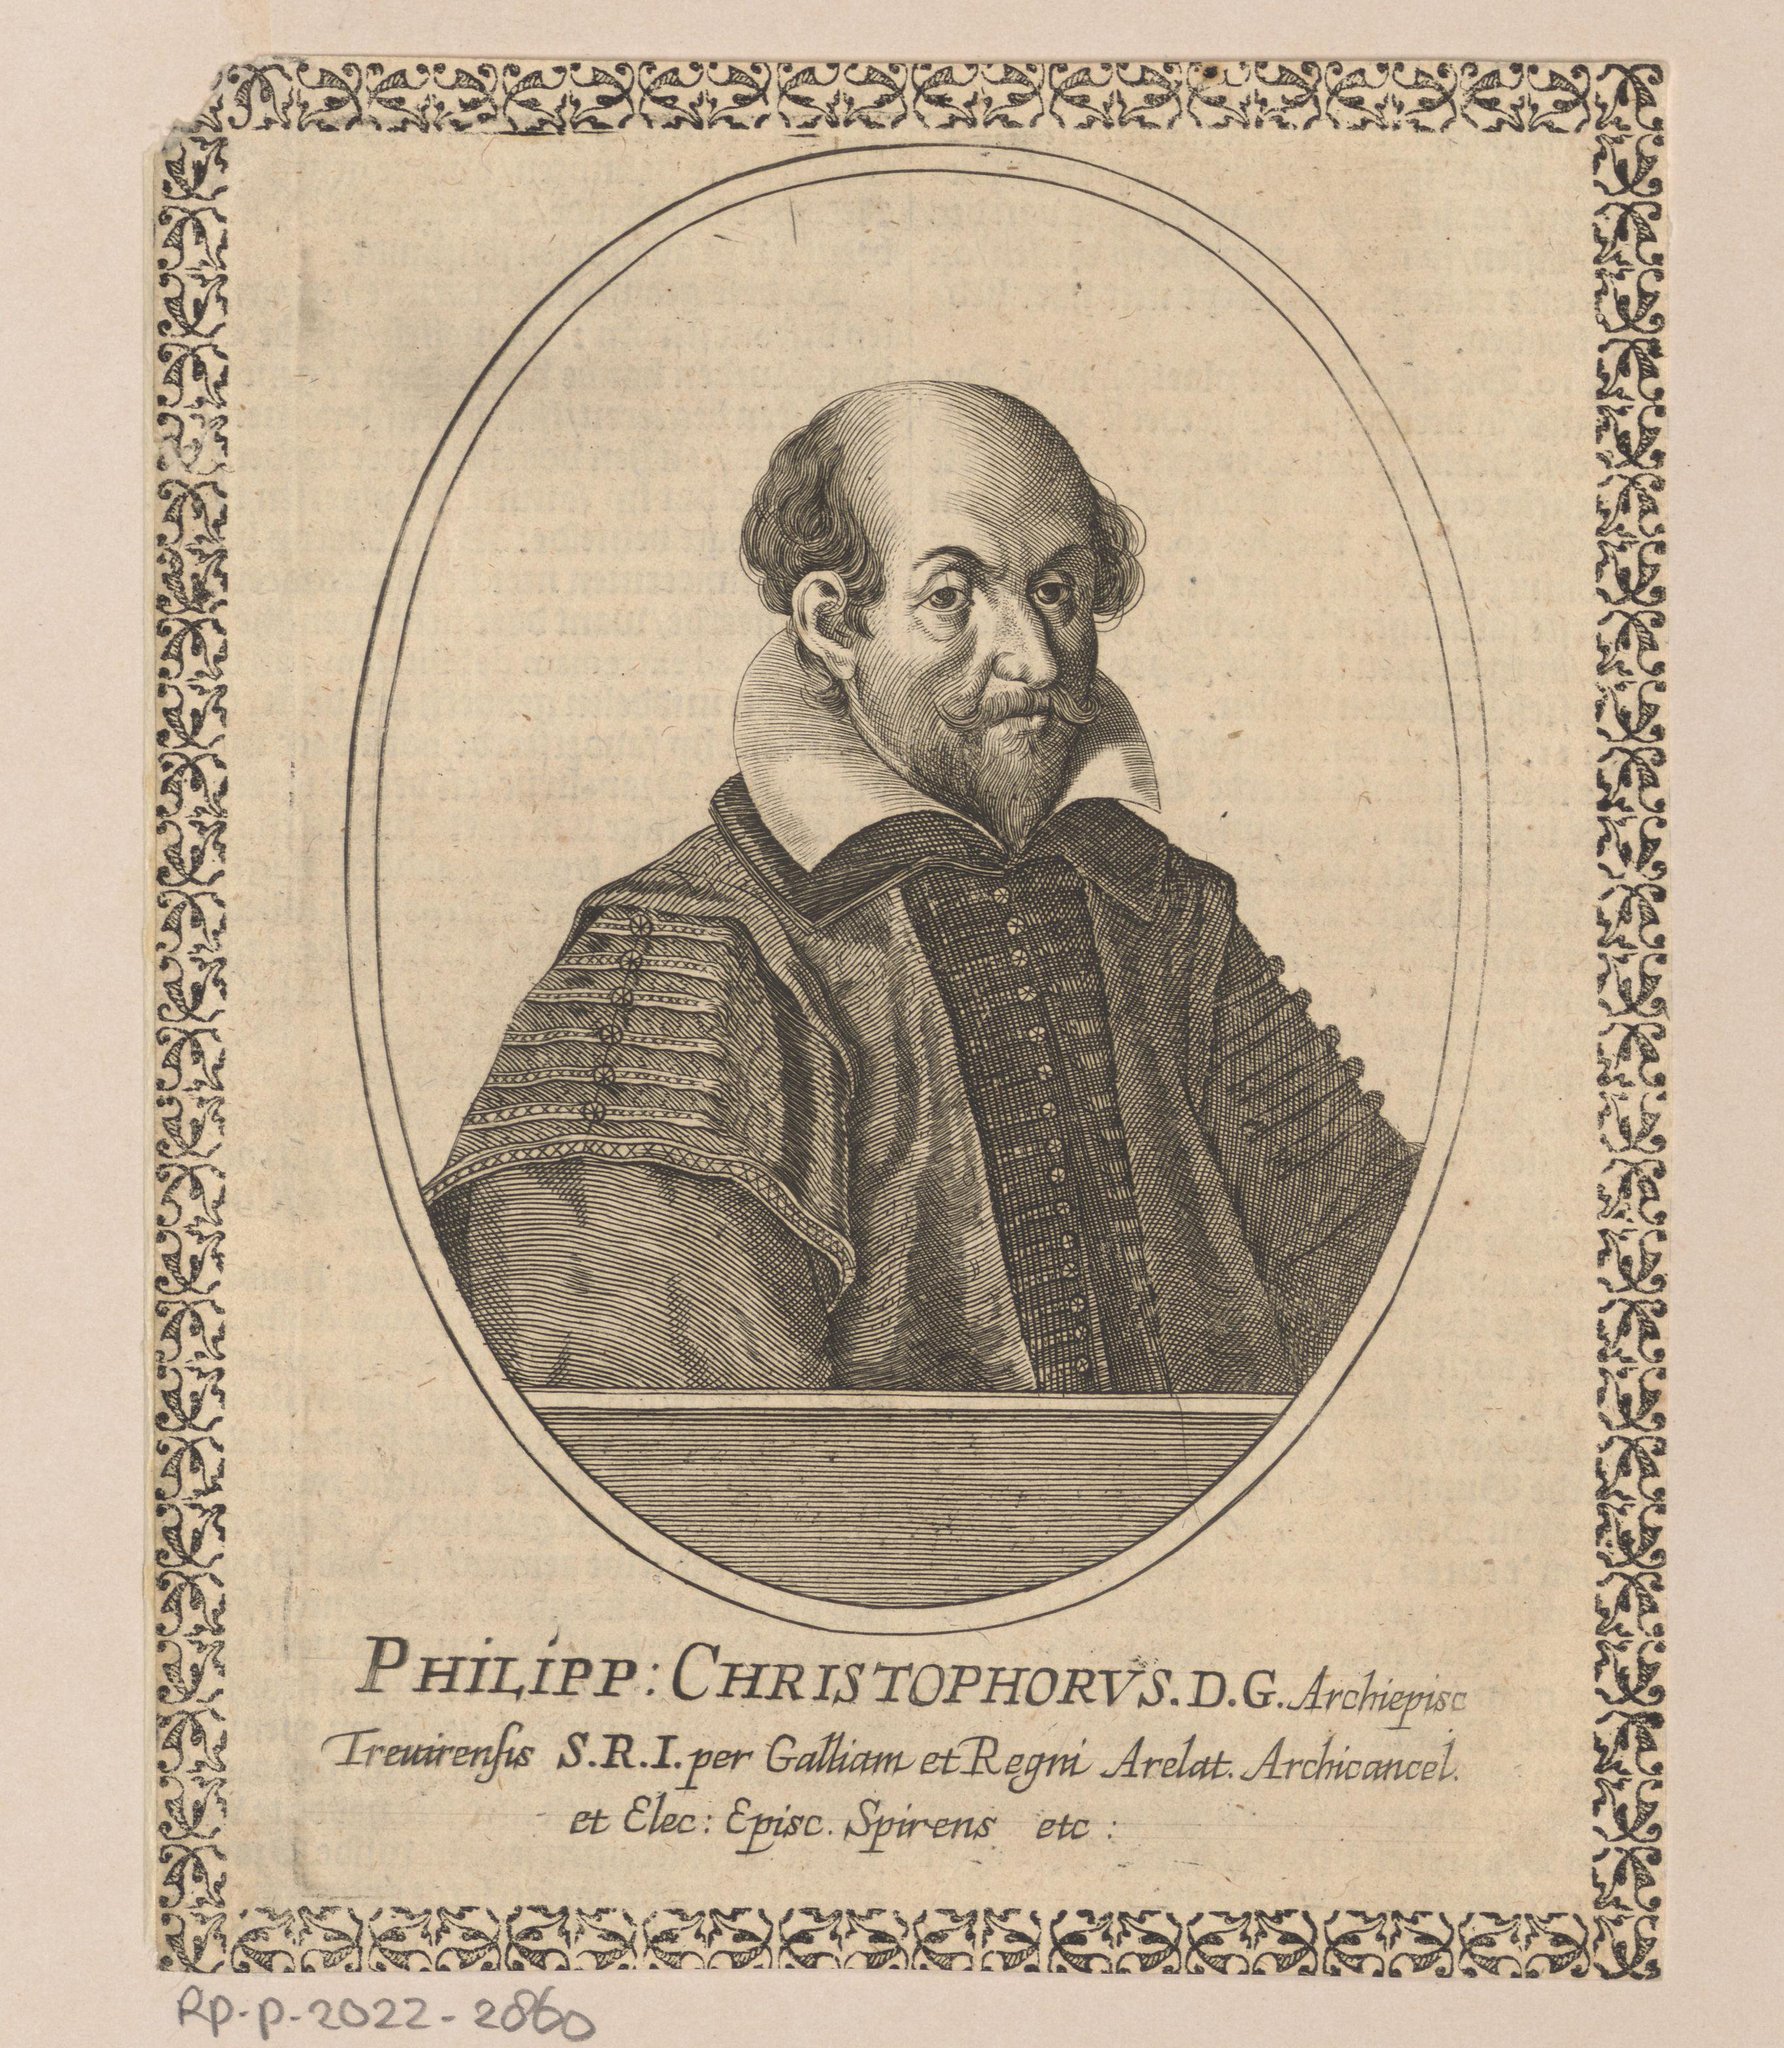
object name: print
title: Portret van Philipp Christoph von Sötern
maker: cornelis danckerts (i)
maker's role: print maker, publisher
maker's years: 1604-1656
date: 1642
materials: paper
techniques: engraving, etching, letterpress printing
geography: amsterdam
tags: archbishop, bishop, etc. (roman catholic), historical persons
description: Prent uit: Abelinus, Johann Philipp. Historis oft Waerachtich Verhael Van den Gantschen toestant van Dorlooge (...). Amsterdam: Cornelis Danckerts (I), 1642.